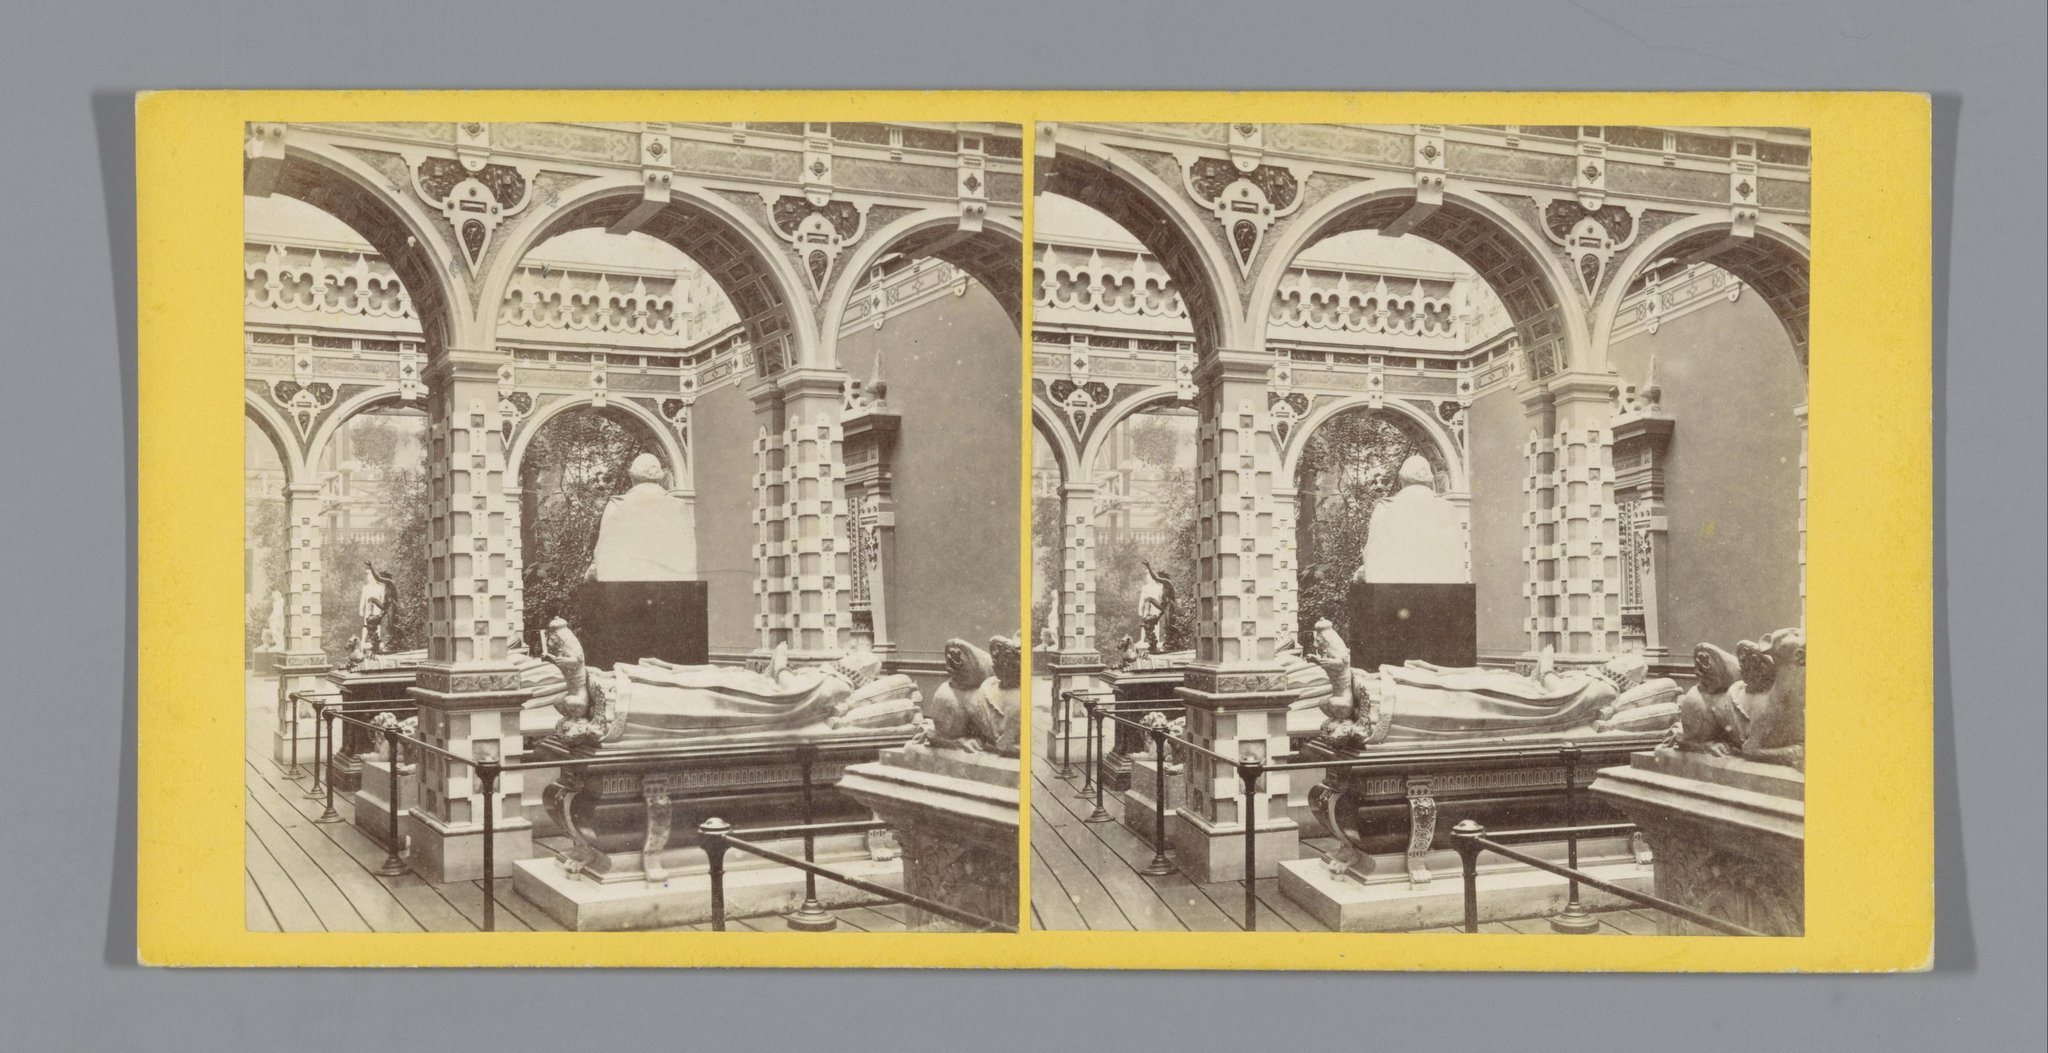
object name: stereograph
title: Elizabethan Court Vestibule in het Crystal Palace in Londen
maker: Anonymous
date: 1860-1865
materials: cardboard, photographic support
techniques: albumen print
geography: crystal palace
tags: piece of sculpture, reproduction of a piece of sculpture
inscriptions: inscription: ‘Elizabethan Vestibule, CP’